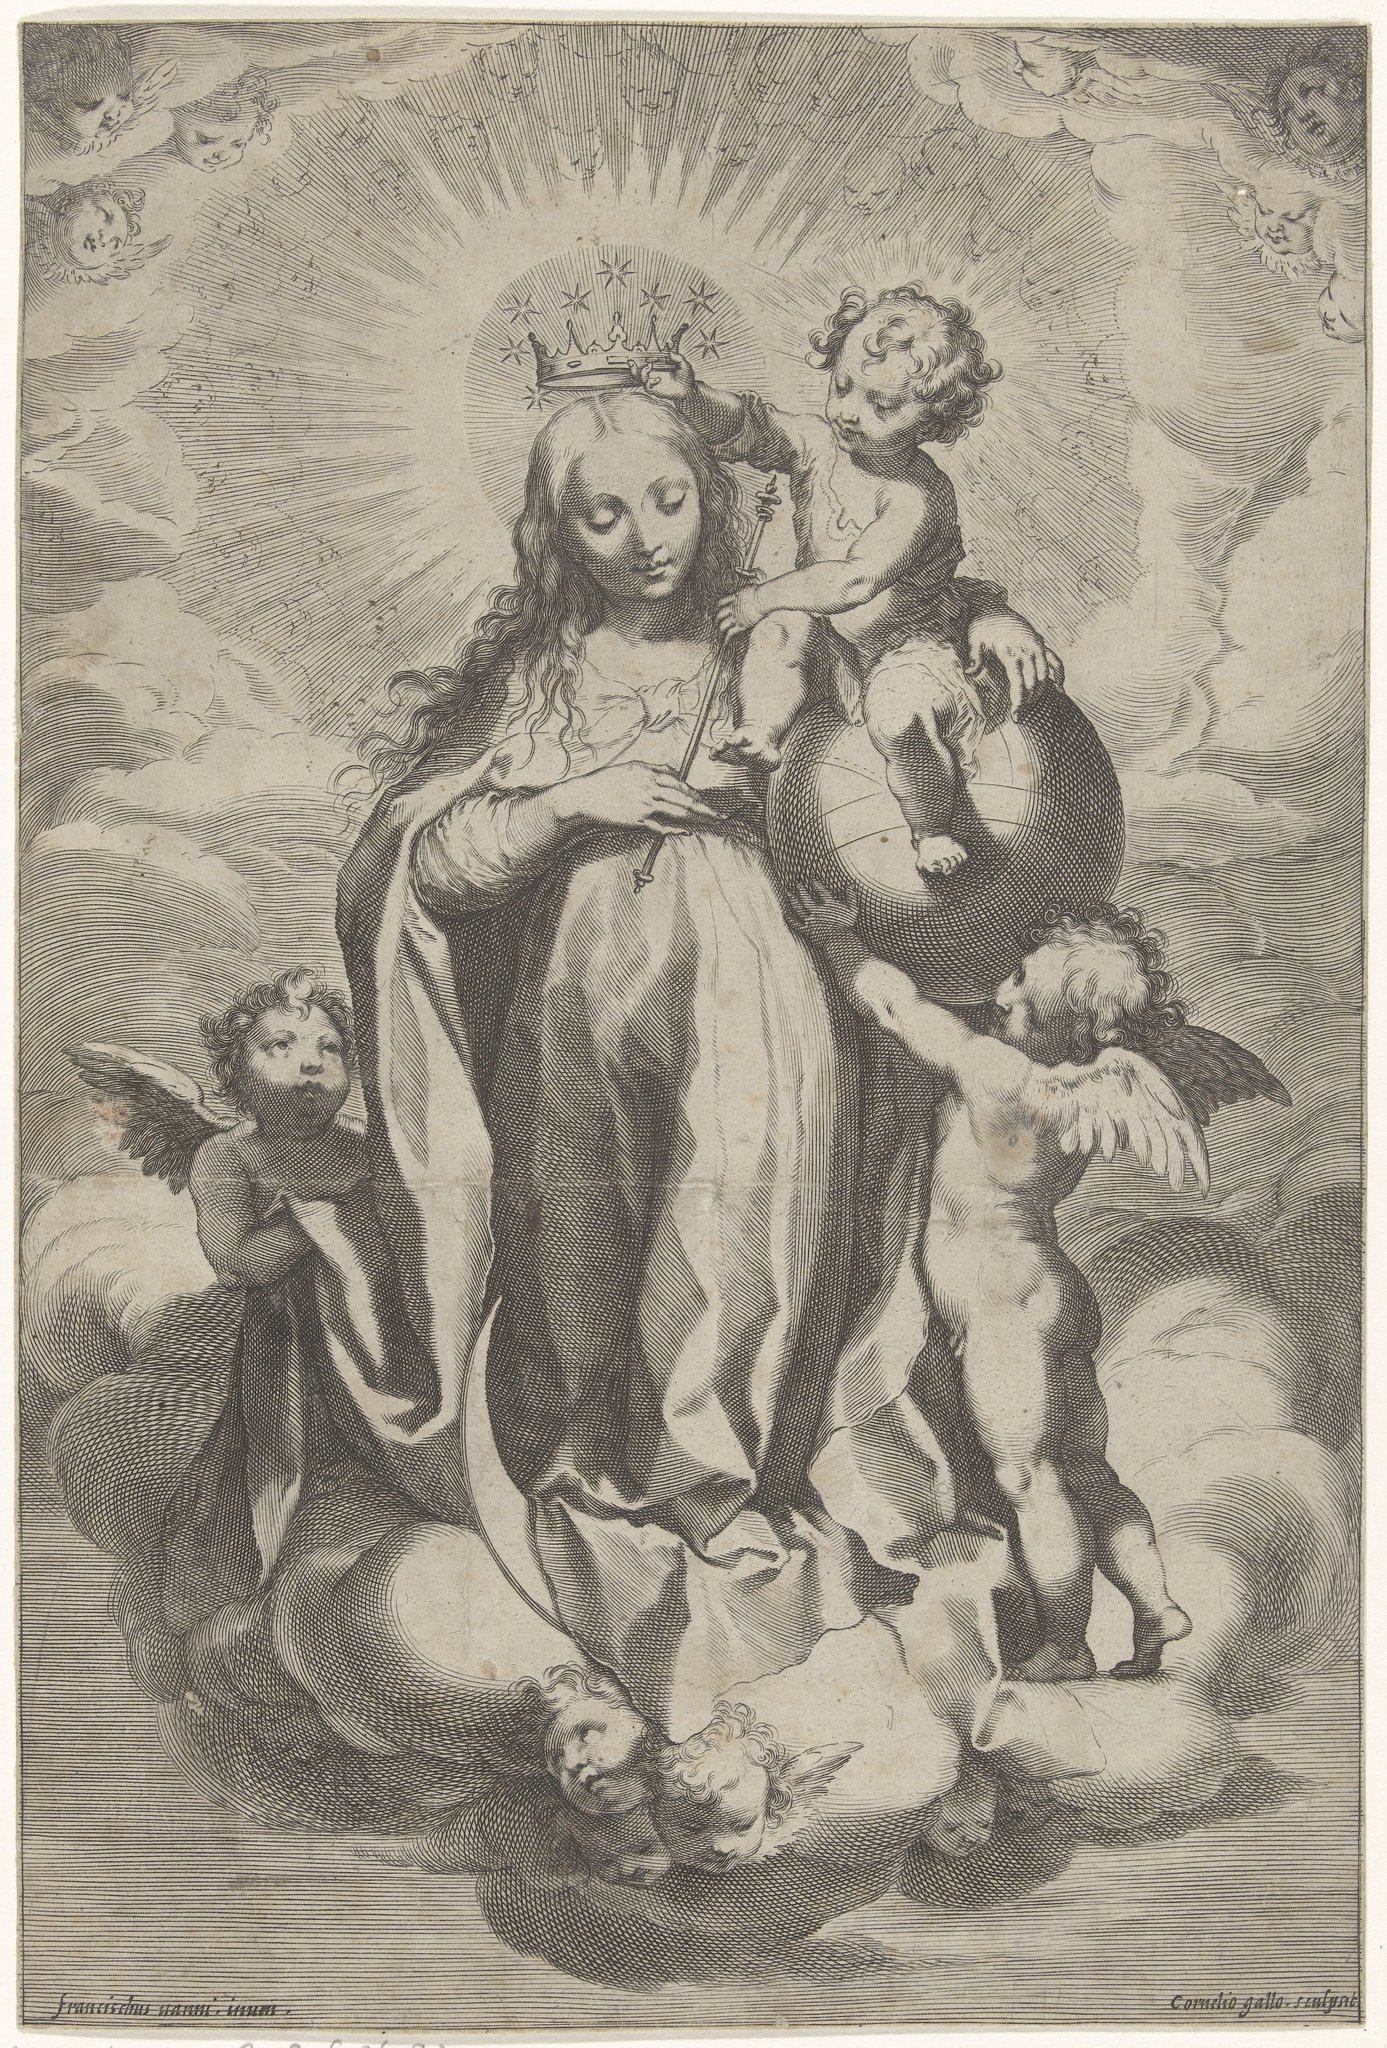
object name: print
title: Kroning van Maria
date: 1586-1612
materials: paper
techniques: engraving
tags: the christ-child crowning mary ~ madonna-representations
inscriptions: collector's mark: Lugt 10, collector's mark: Lugt 11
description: Het Christuskind kroont Maria en overhandigt haar een scepter. Christus zit op een globe die gedragen wordt door een engel. Maria staat op een maansikkel, haar hoofd wordt omgeven door een krans van cherubijnen.